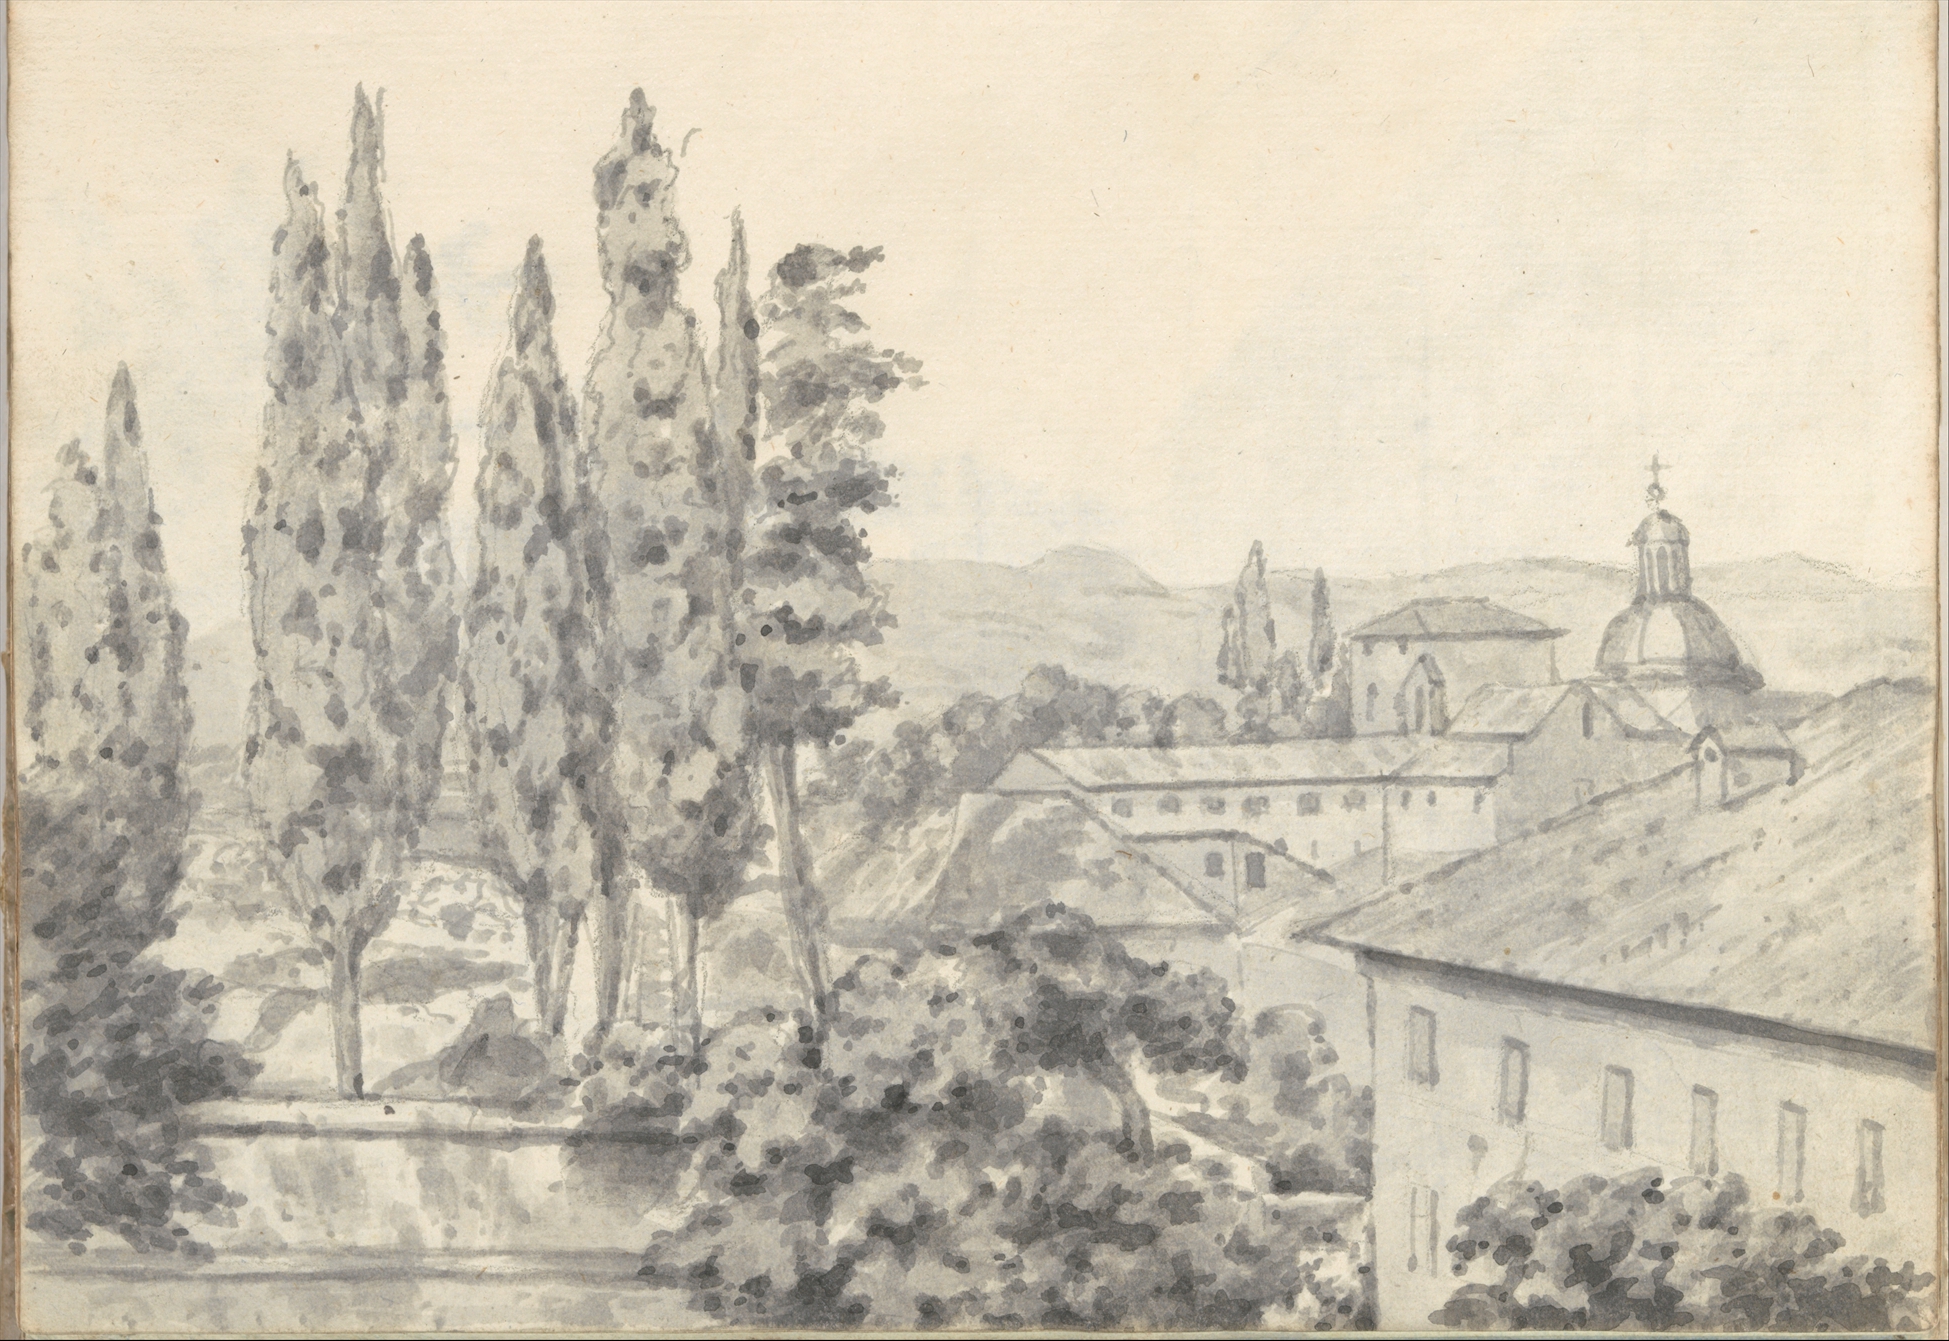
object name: drawing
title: Institutional buildings, a garden, and a church at Rome (Smaller Italian sketchbook, leaf 6 recto)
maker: joseph wright (wright of derby)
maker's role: artist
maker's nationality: british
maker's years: 1734-1797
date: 1774-1775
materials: ink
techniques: brush, wash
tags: houses,churches,landscapes